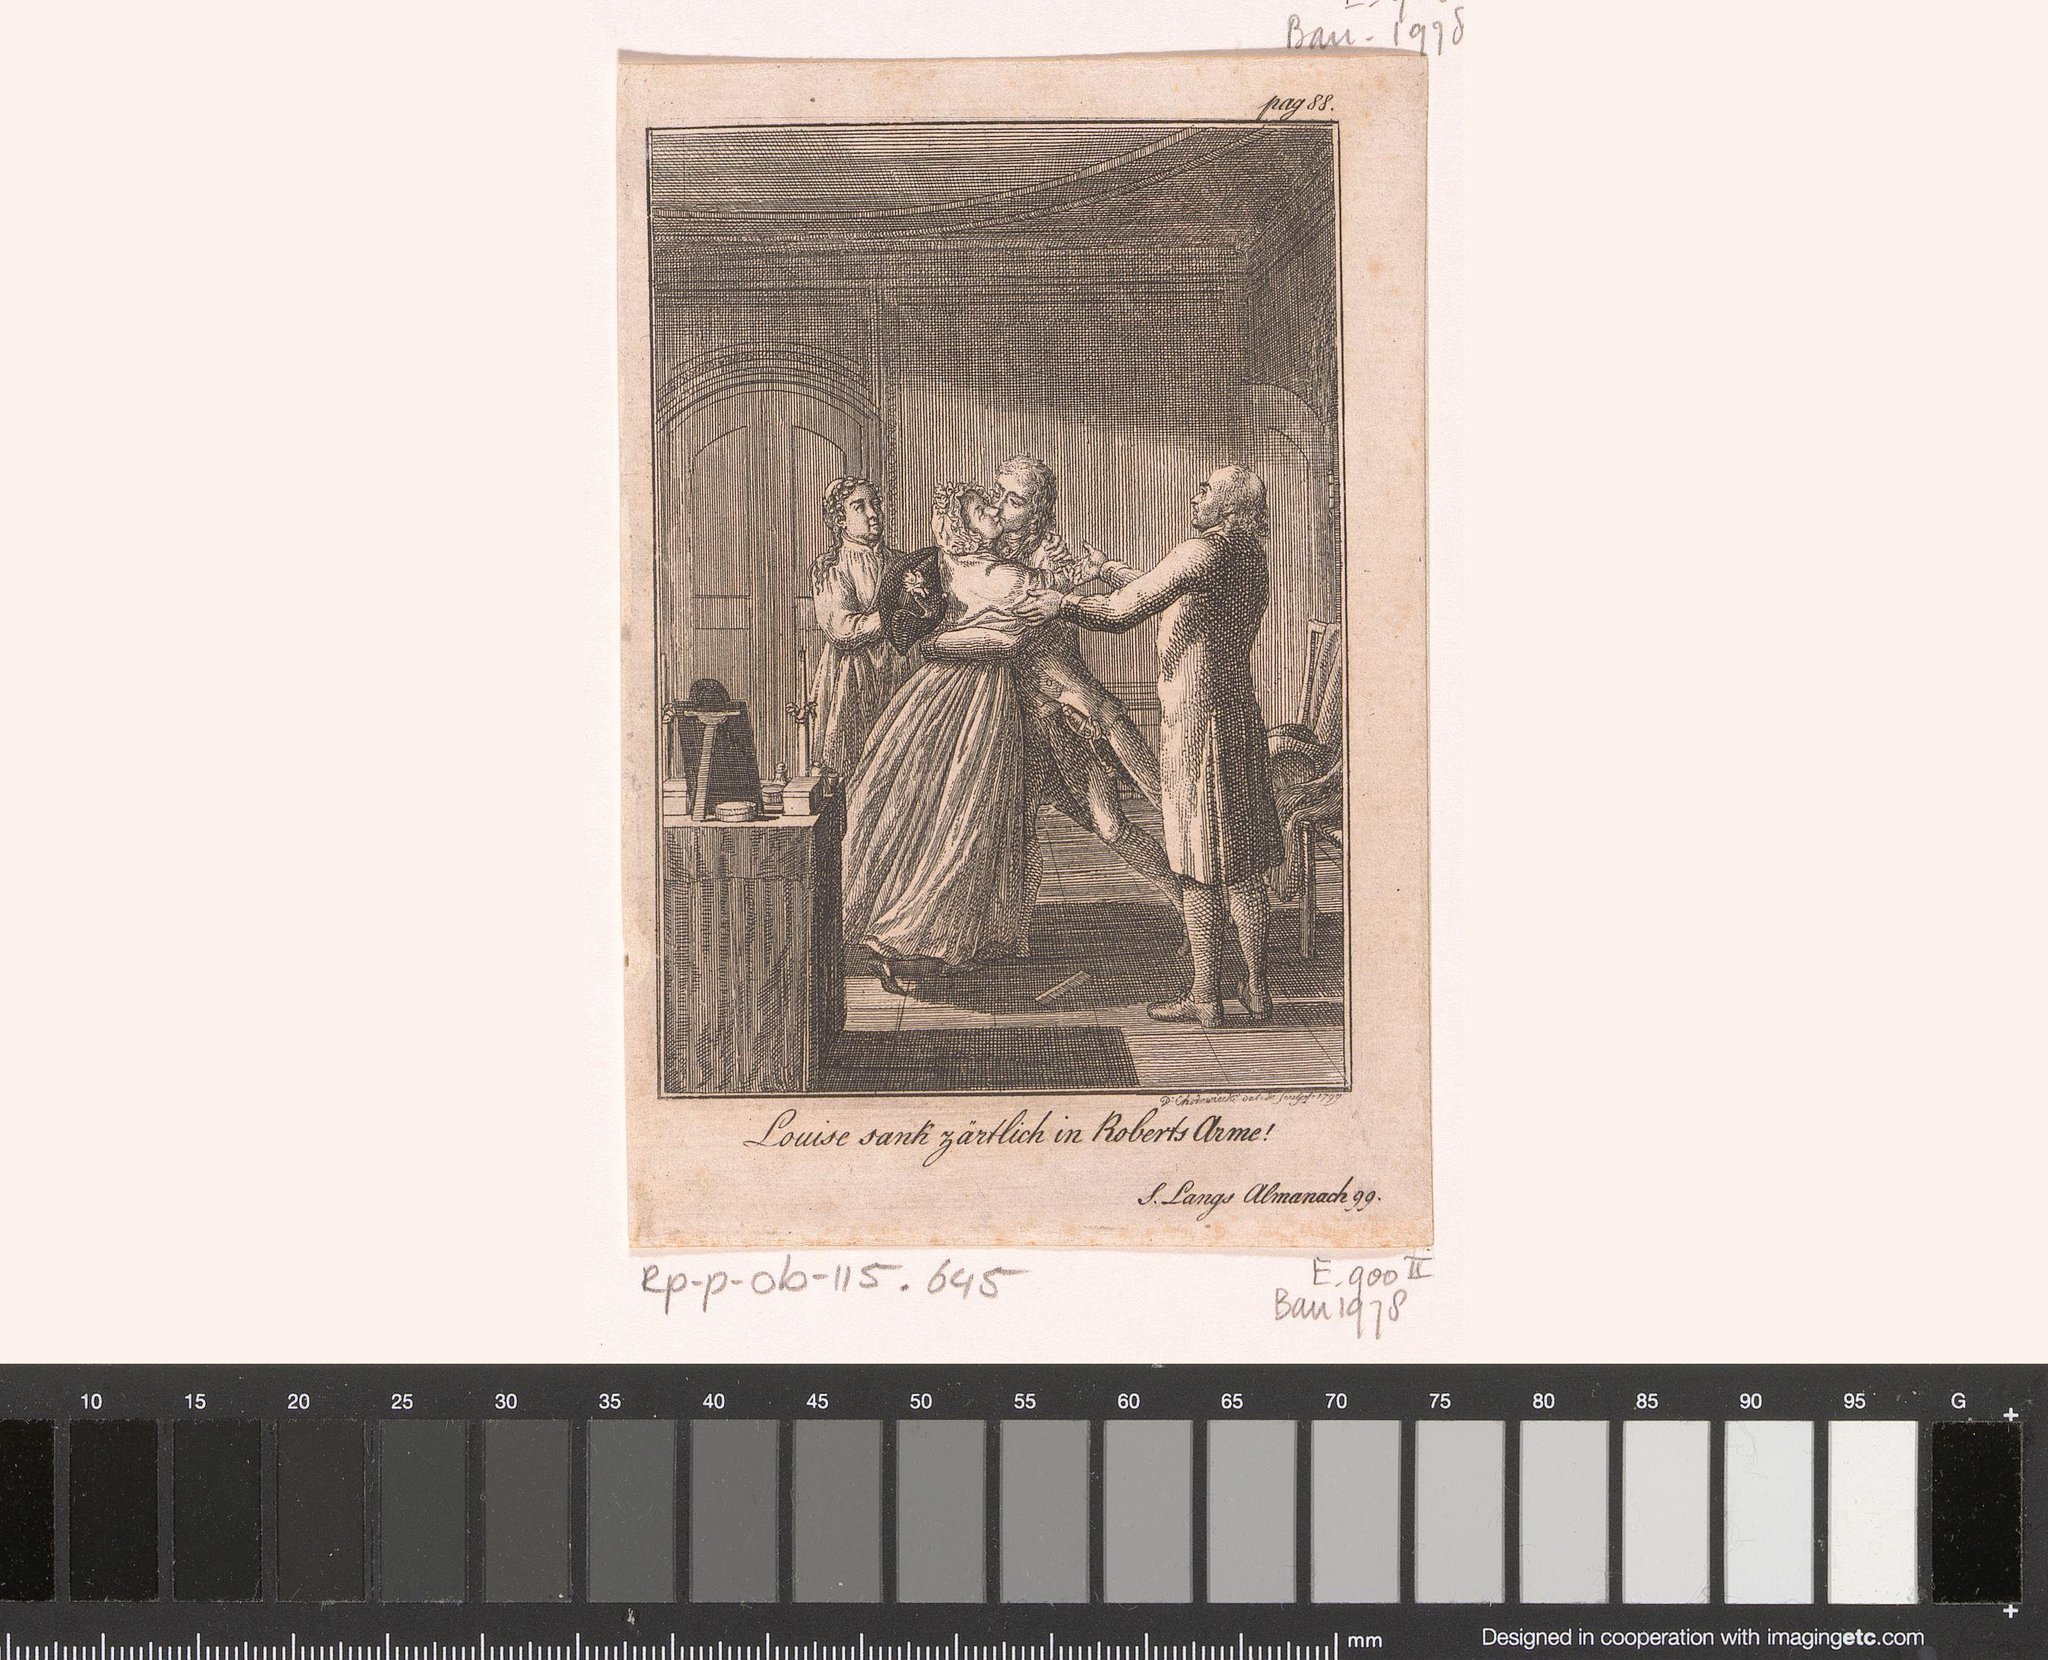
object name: print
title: Luise en Robert omhelzen elkaar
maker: daniel nikolaus chodowiecki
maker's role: draughtsman, print maker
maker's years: 1726-1801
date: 1799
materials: paper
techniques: etching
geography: berlin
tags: (lovers) embracing each other, 'symplegma'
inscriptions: collector's mark: Lugt 2228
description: Prent gebruikt voor: Lang, Karl. Almanach und Taschenbuch für Häusliche und Gesellschaftliche Freuden (...). Heilbronn: Industrie Comtoir, 1799.